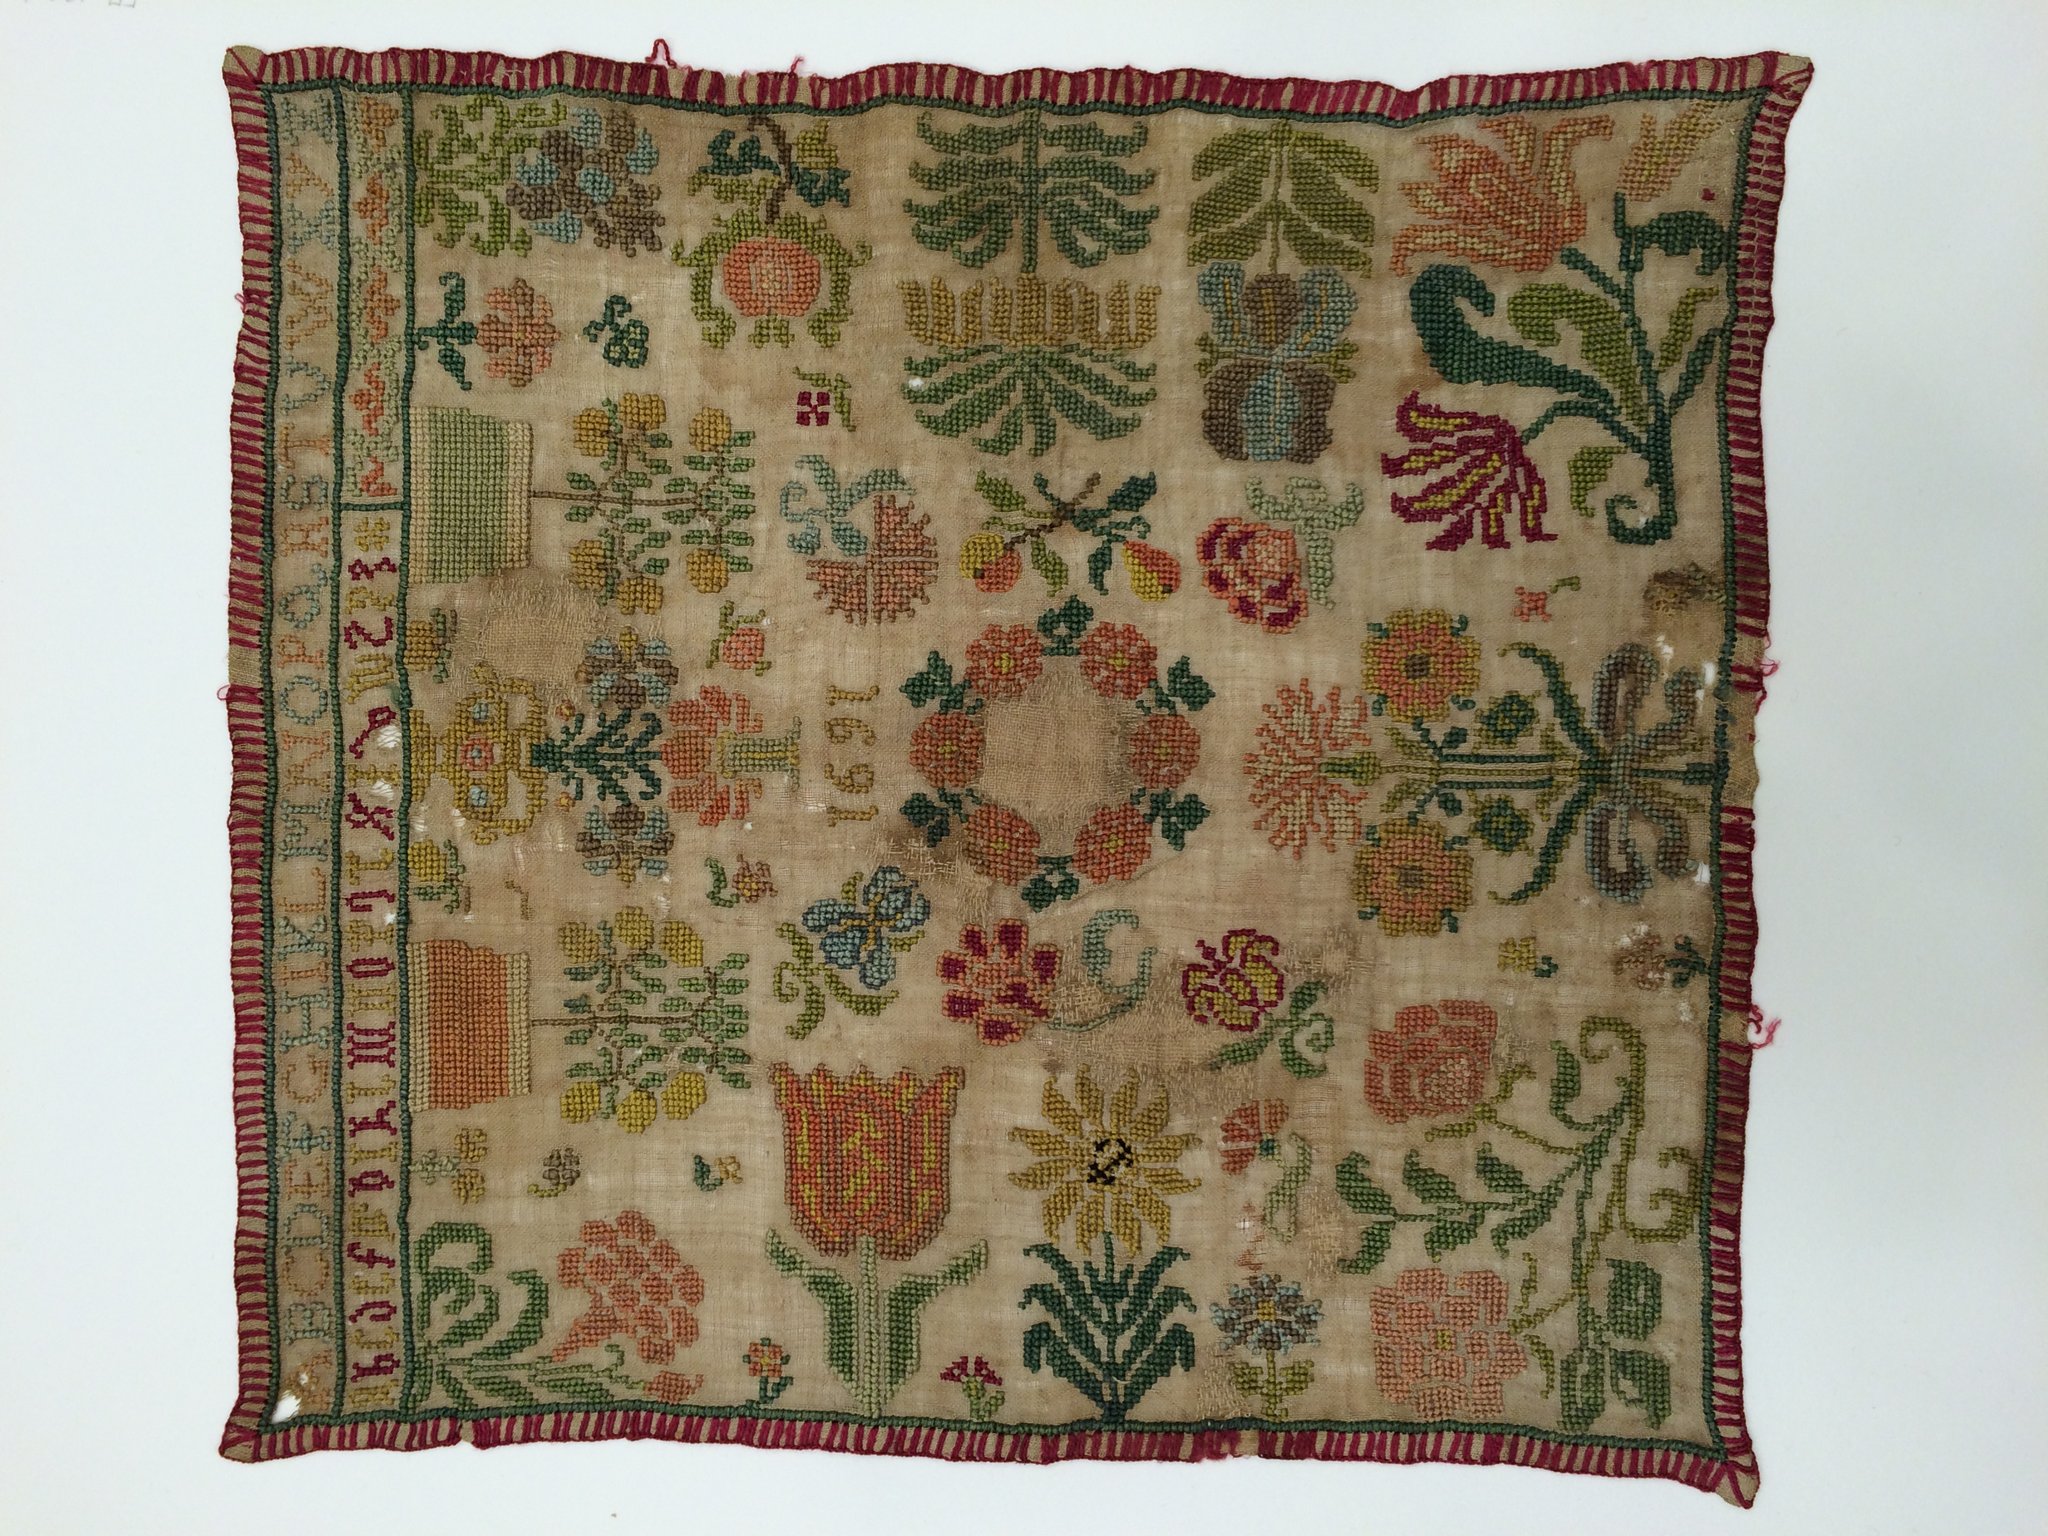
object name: sampler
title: Embroidered sampler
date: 1691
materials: linen, silk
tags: flowers